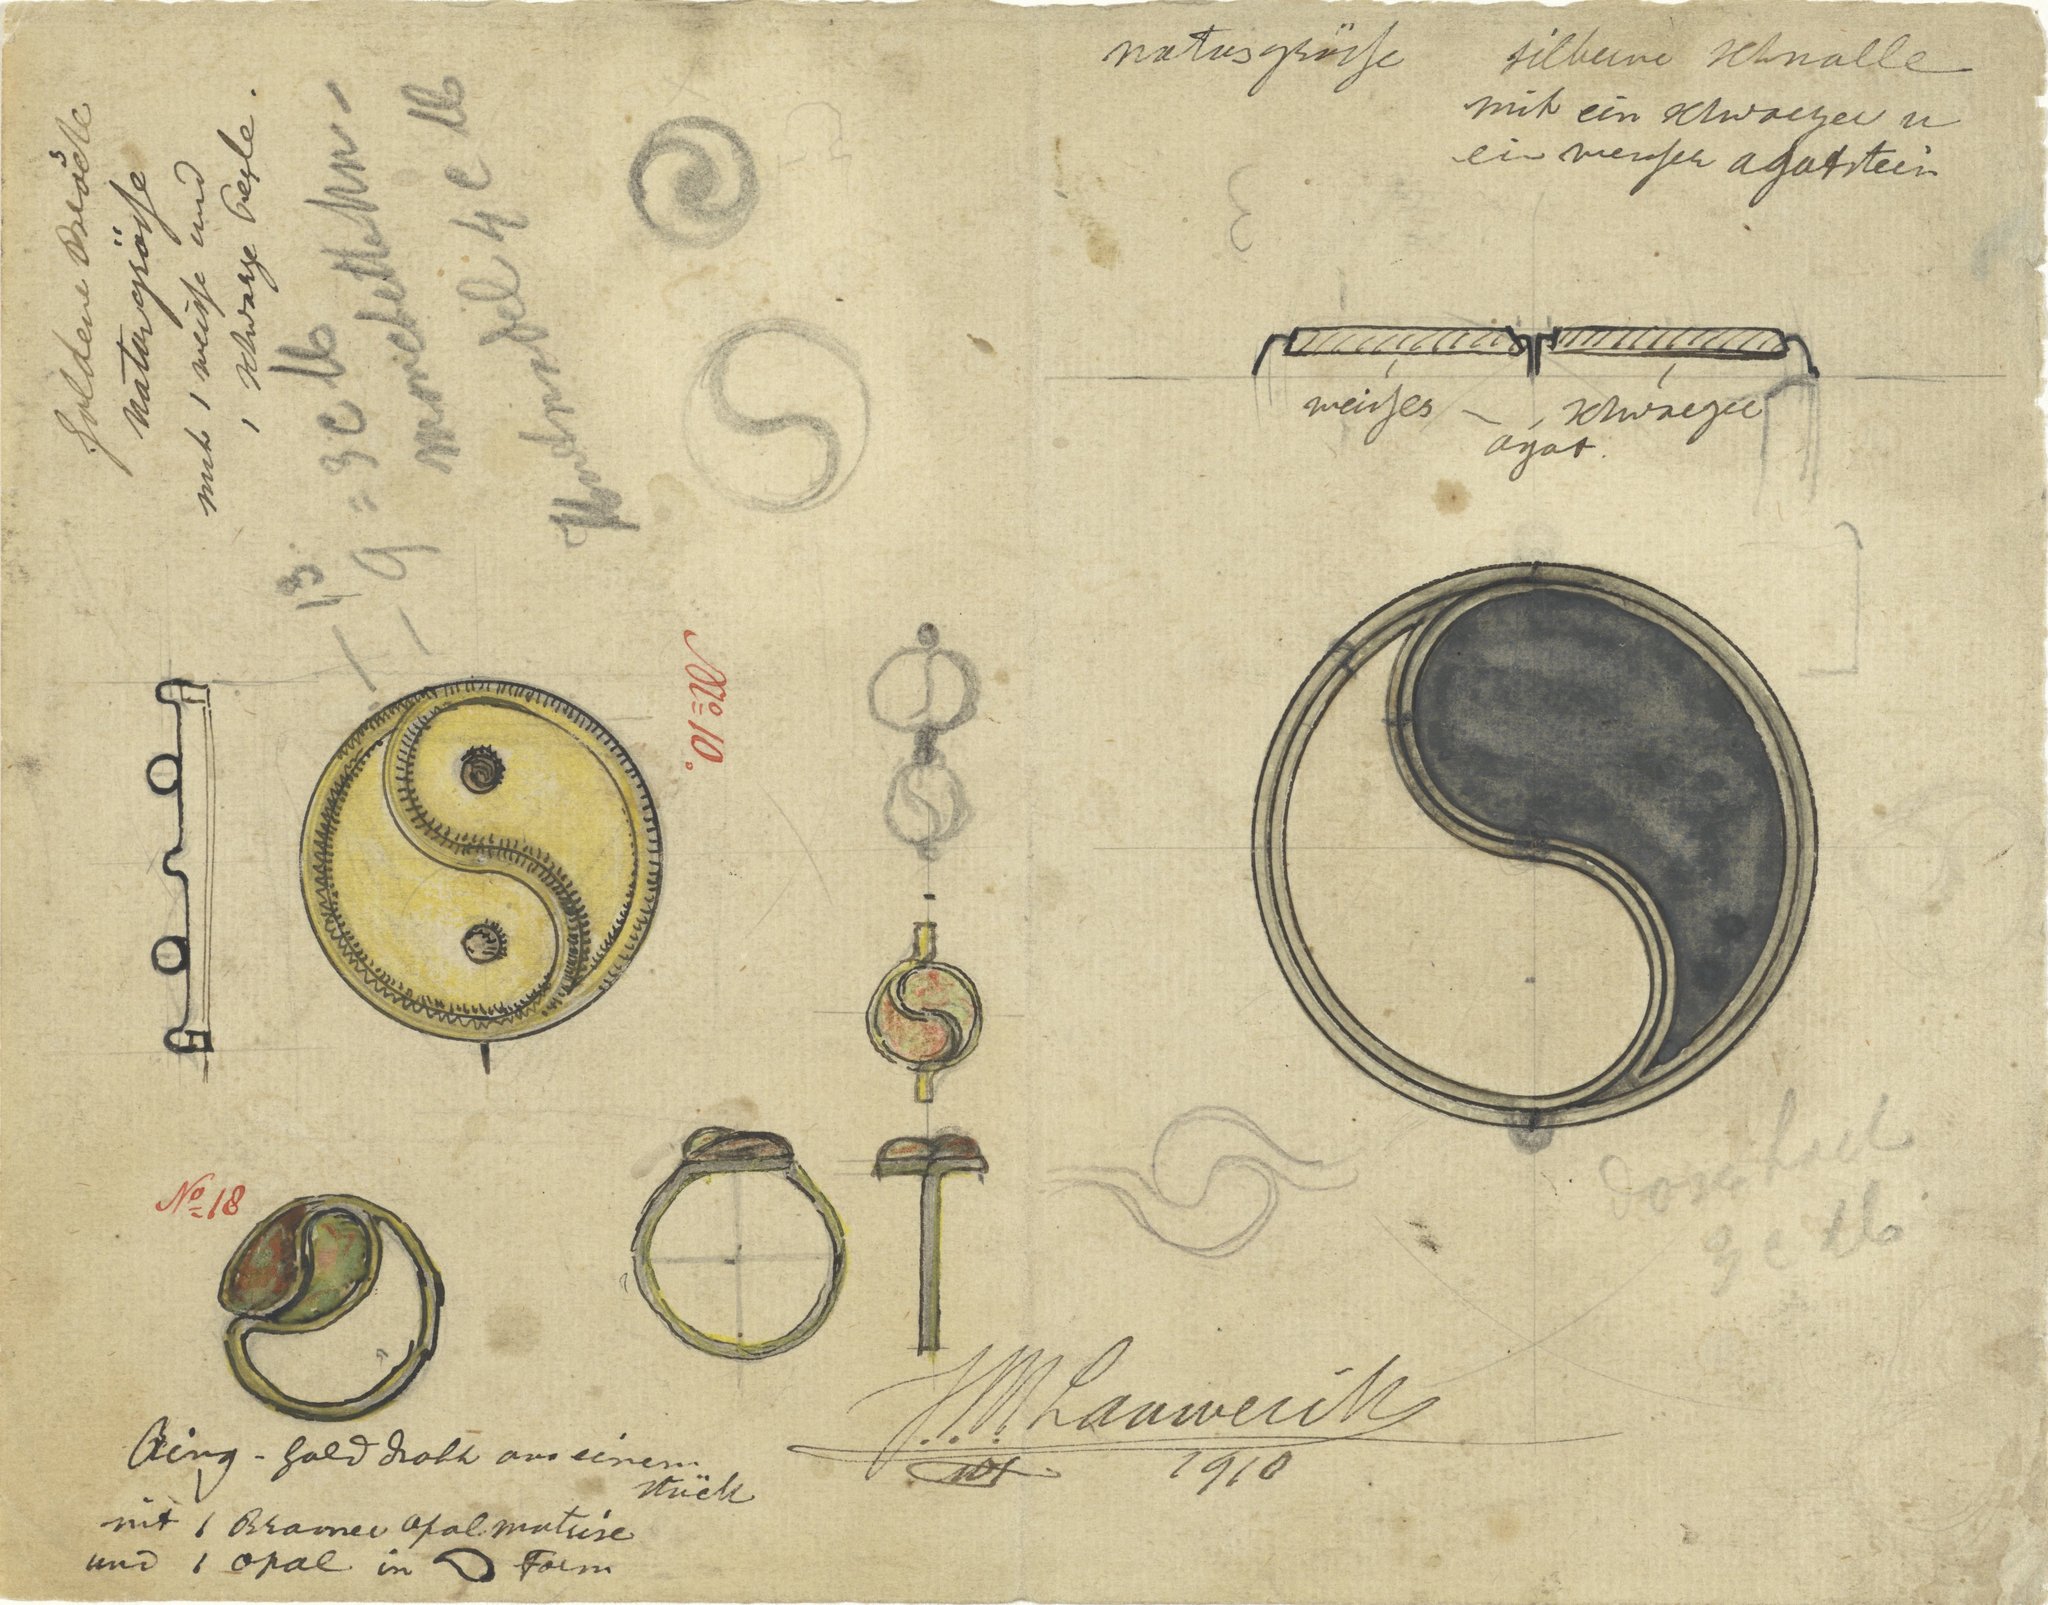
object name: design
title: Ontwerpen voor een broche, ring en gesp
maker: mathieu lauweriks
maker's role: designer, draughtsman, print maker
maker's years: 1864-1932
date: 1910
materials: ink, paper, pencil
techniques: brush, pen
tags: buckle, ornament ~ yin-yang, brooch, agraffe, clasp, ring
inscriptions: date: ‘1910’